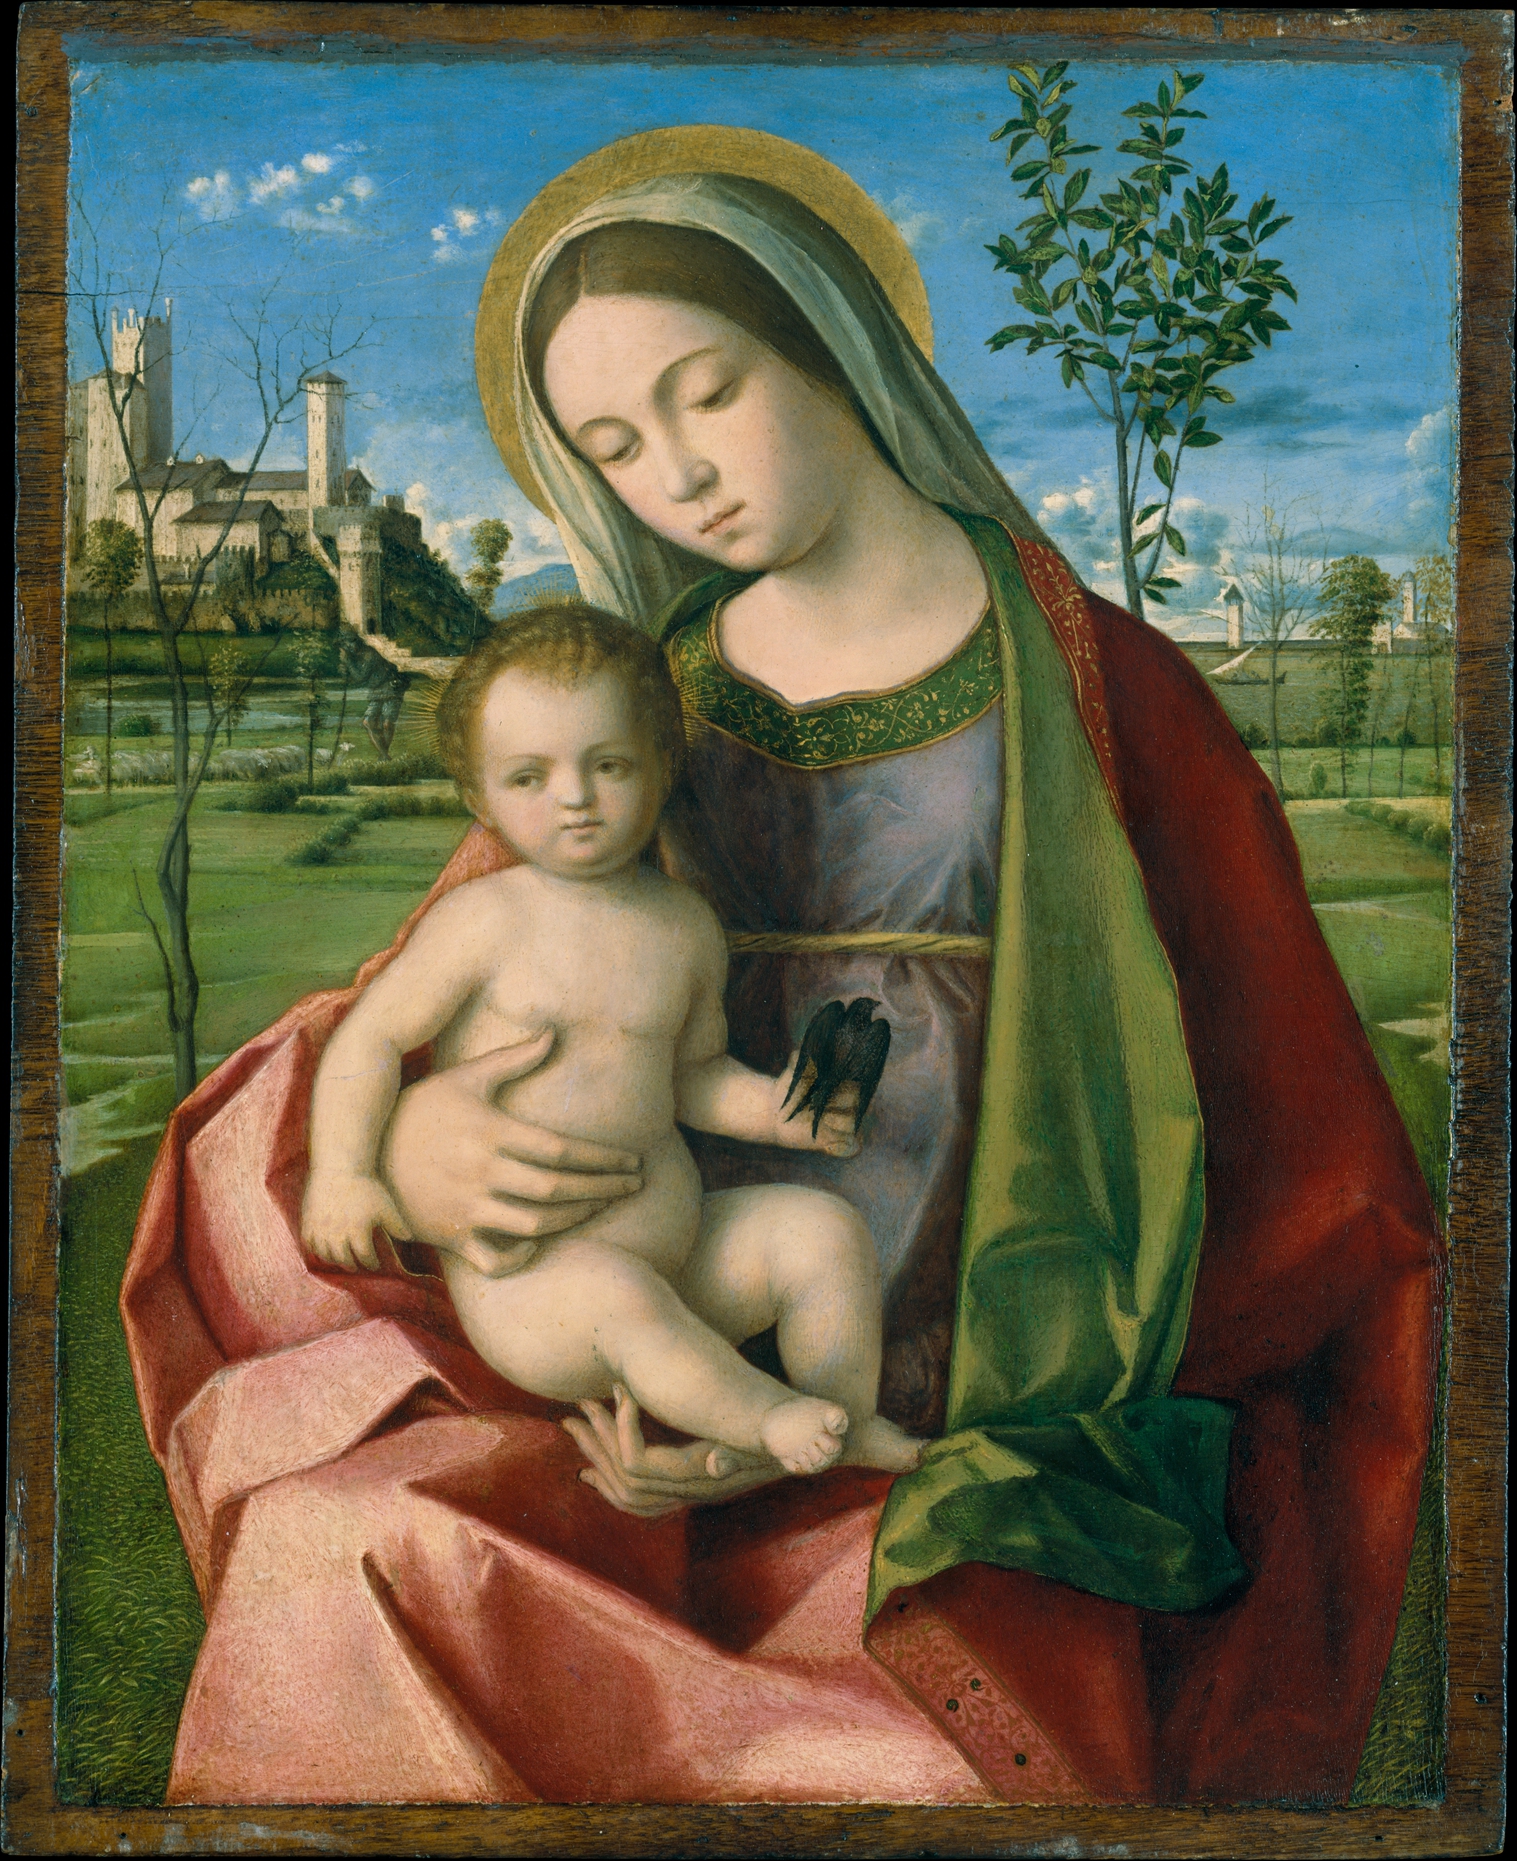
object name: painting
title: Madonna and Child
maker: giovanni bellini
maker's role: artist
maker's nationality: italian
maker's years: 1424-1516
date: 1510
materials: oil, wood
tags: birds,madonna and child